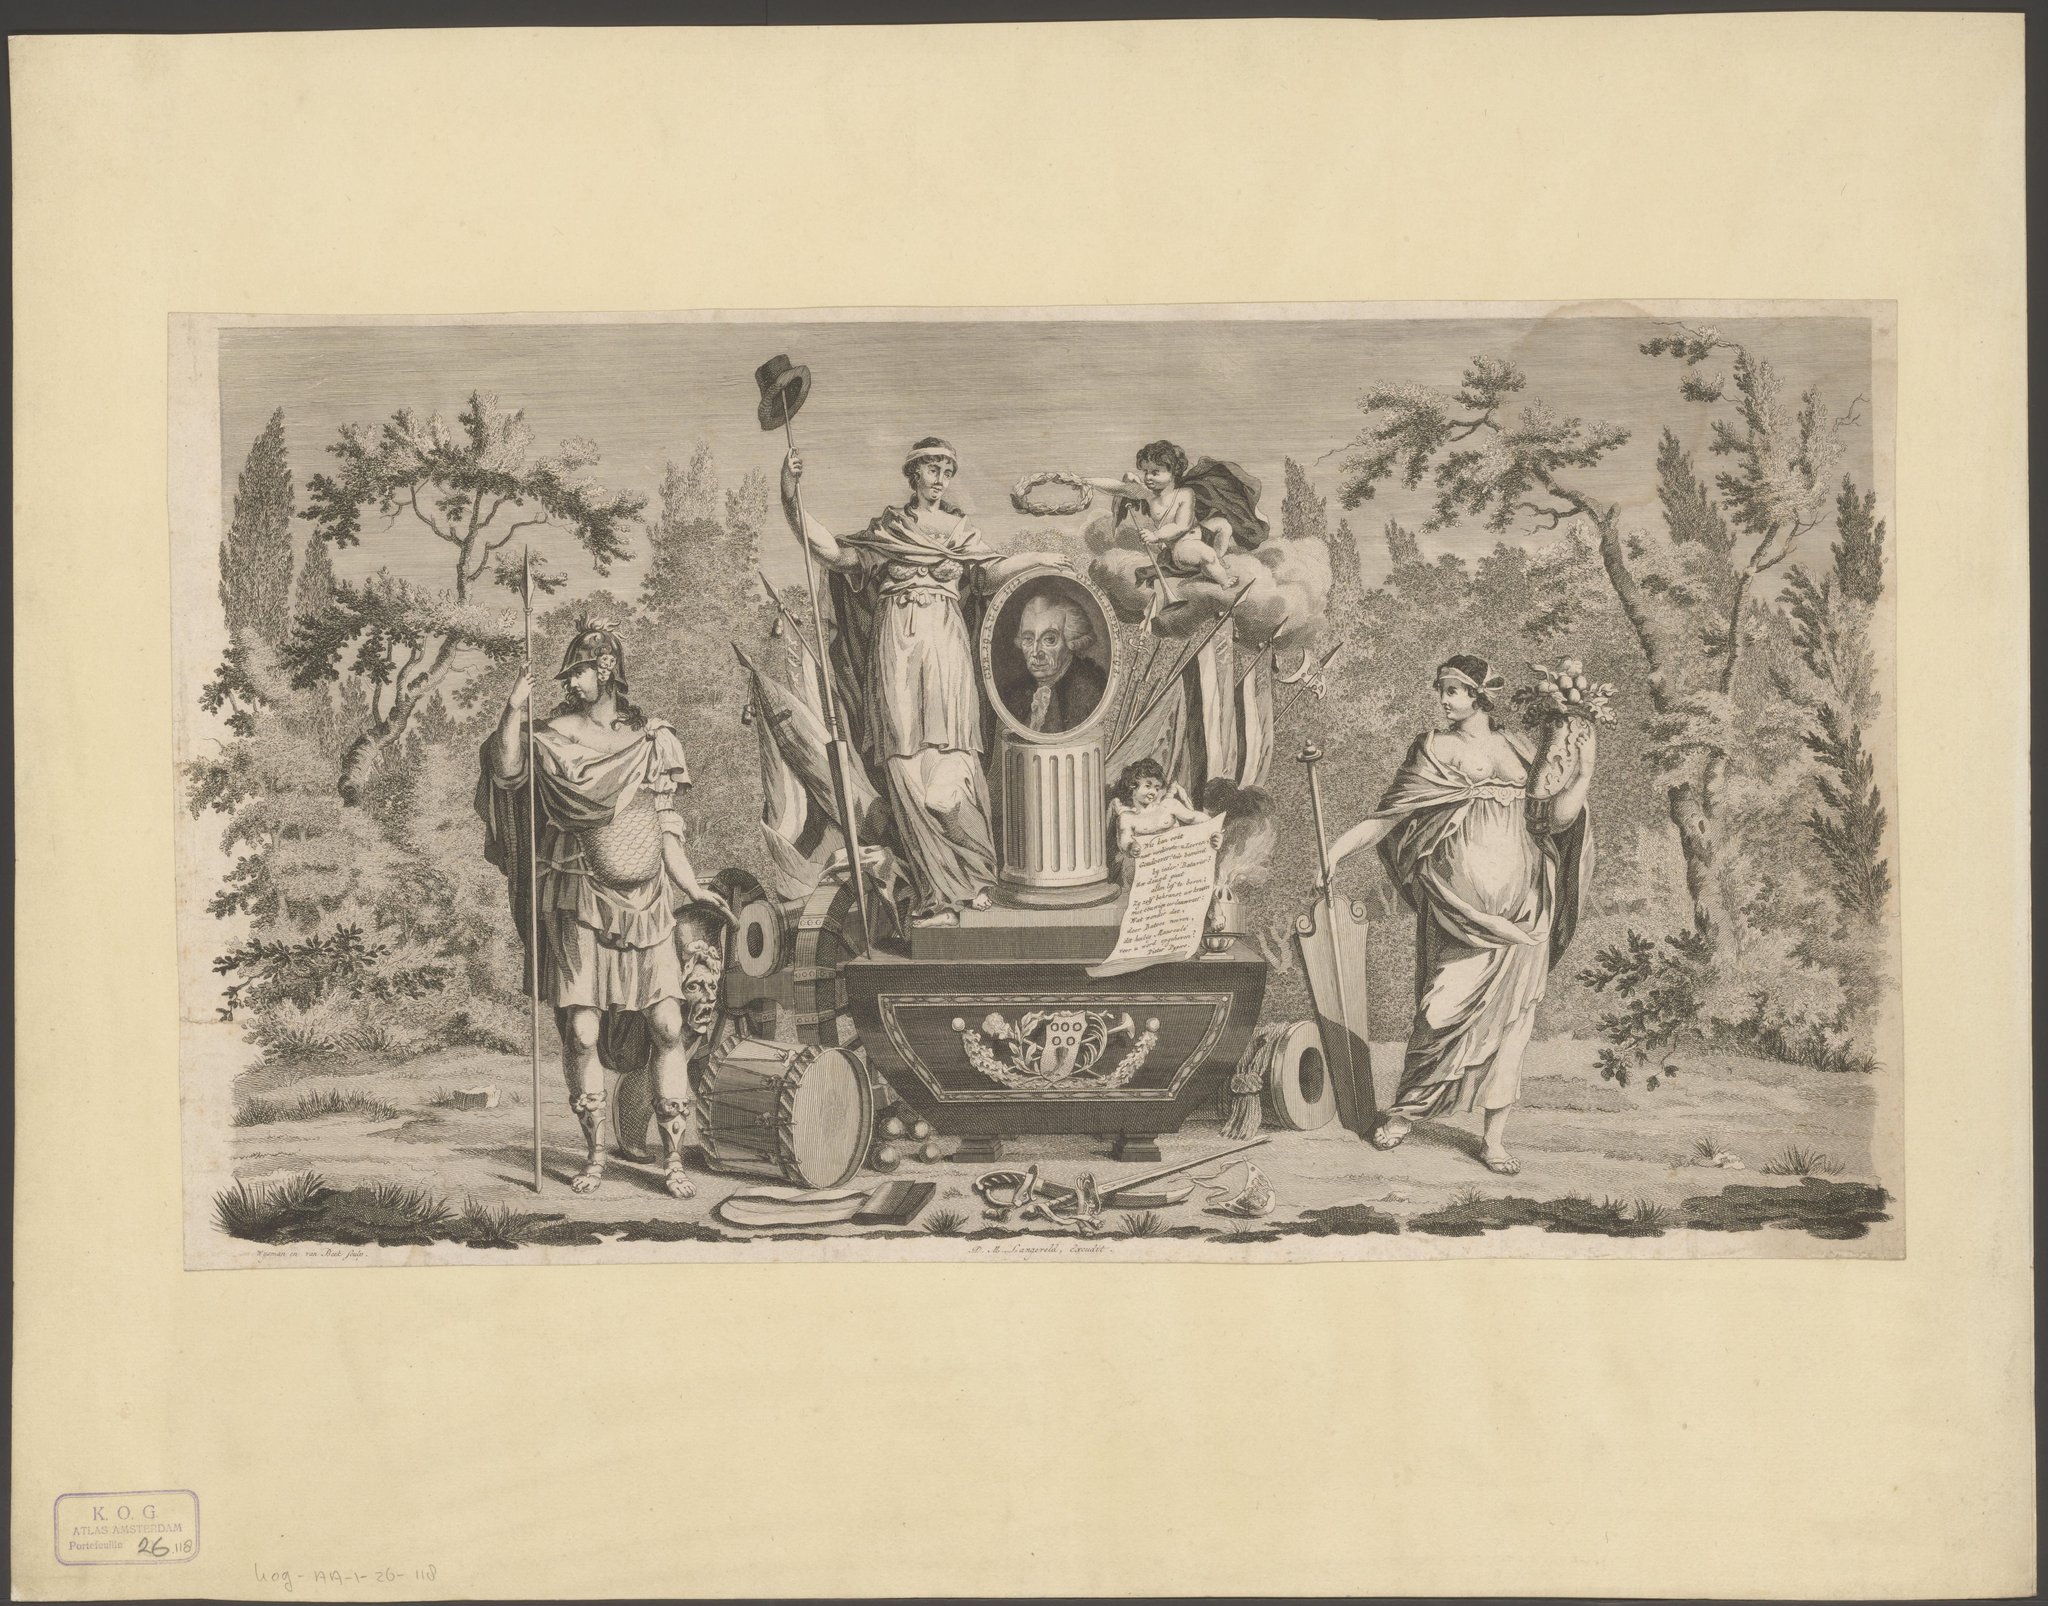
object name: print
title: Allegorisch grafmonument voor Isaac van Goudoever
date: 1793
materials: paper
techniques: etching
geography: amsterdam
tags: amsterdam, symbols, allegories of peace, 'pax'; 'pace' (ripa), historical persons, freedom, liberty; 'libertà' (ripa), grave-building, monumental tomb, cupids: 'amores', 'amoretti', 'putti', armorial bearing, heraldry, courage, bravery, valiance, manliness; 'ardire magnanimo et generoso', 'gagliardezza', 'valore', 'virtù heroica', 'virtù dell'animo e del corpo' (ripa)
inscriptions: collector's mark: Lugt 1641b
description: Onderwerpsrubriek binnen de Atlas Amsterdam: Herinneringen aan de Schutterij.